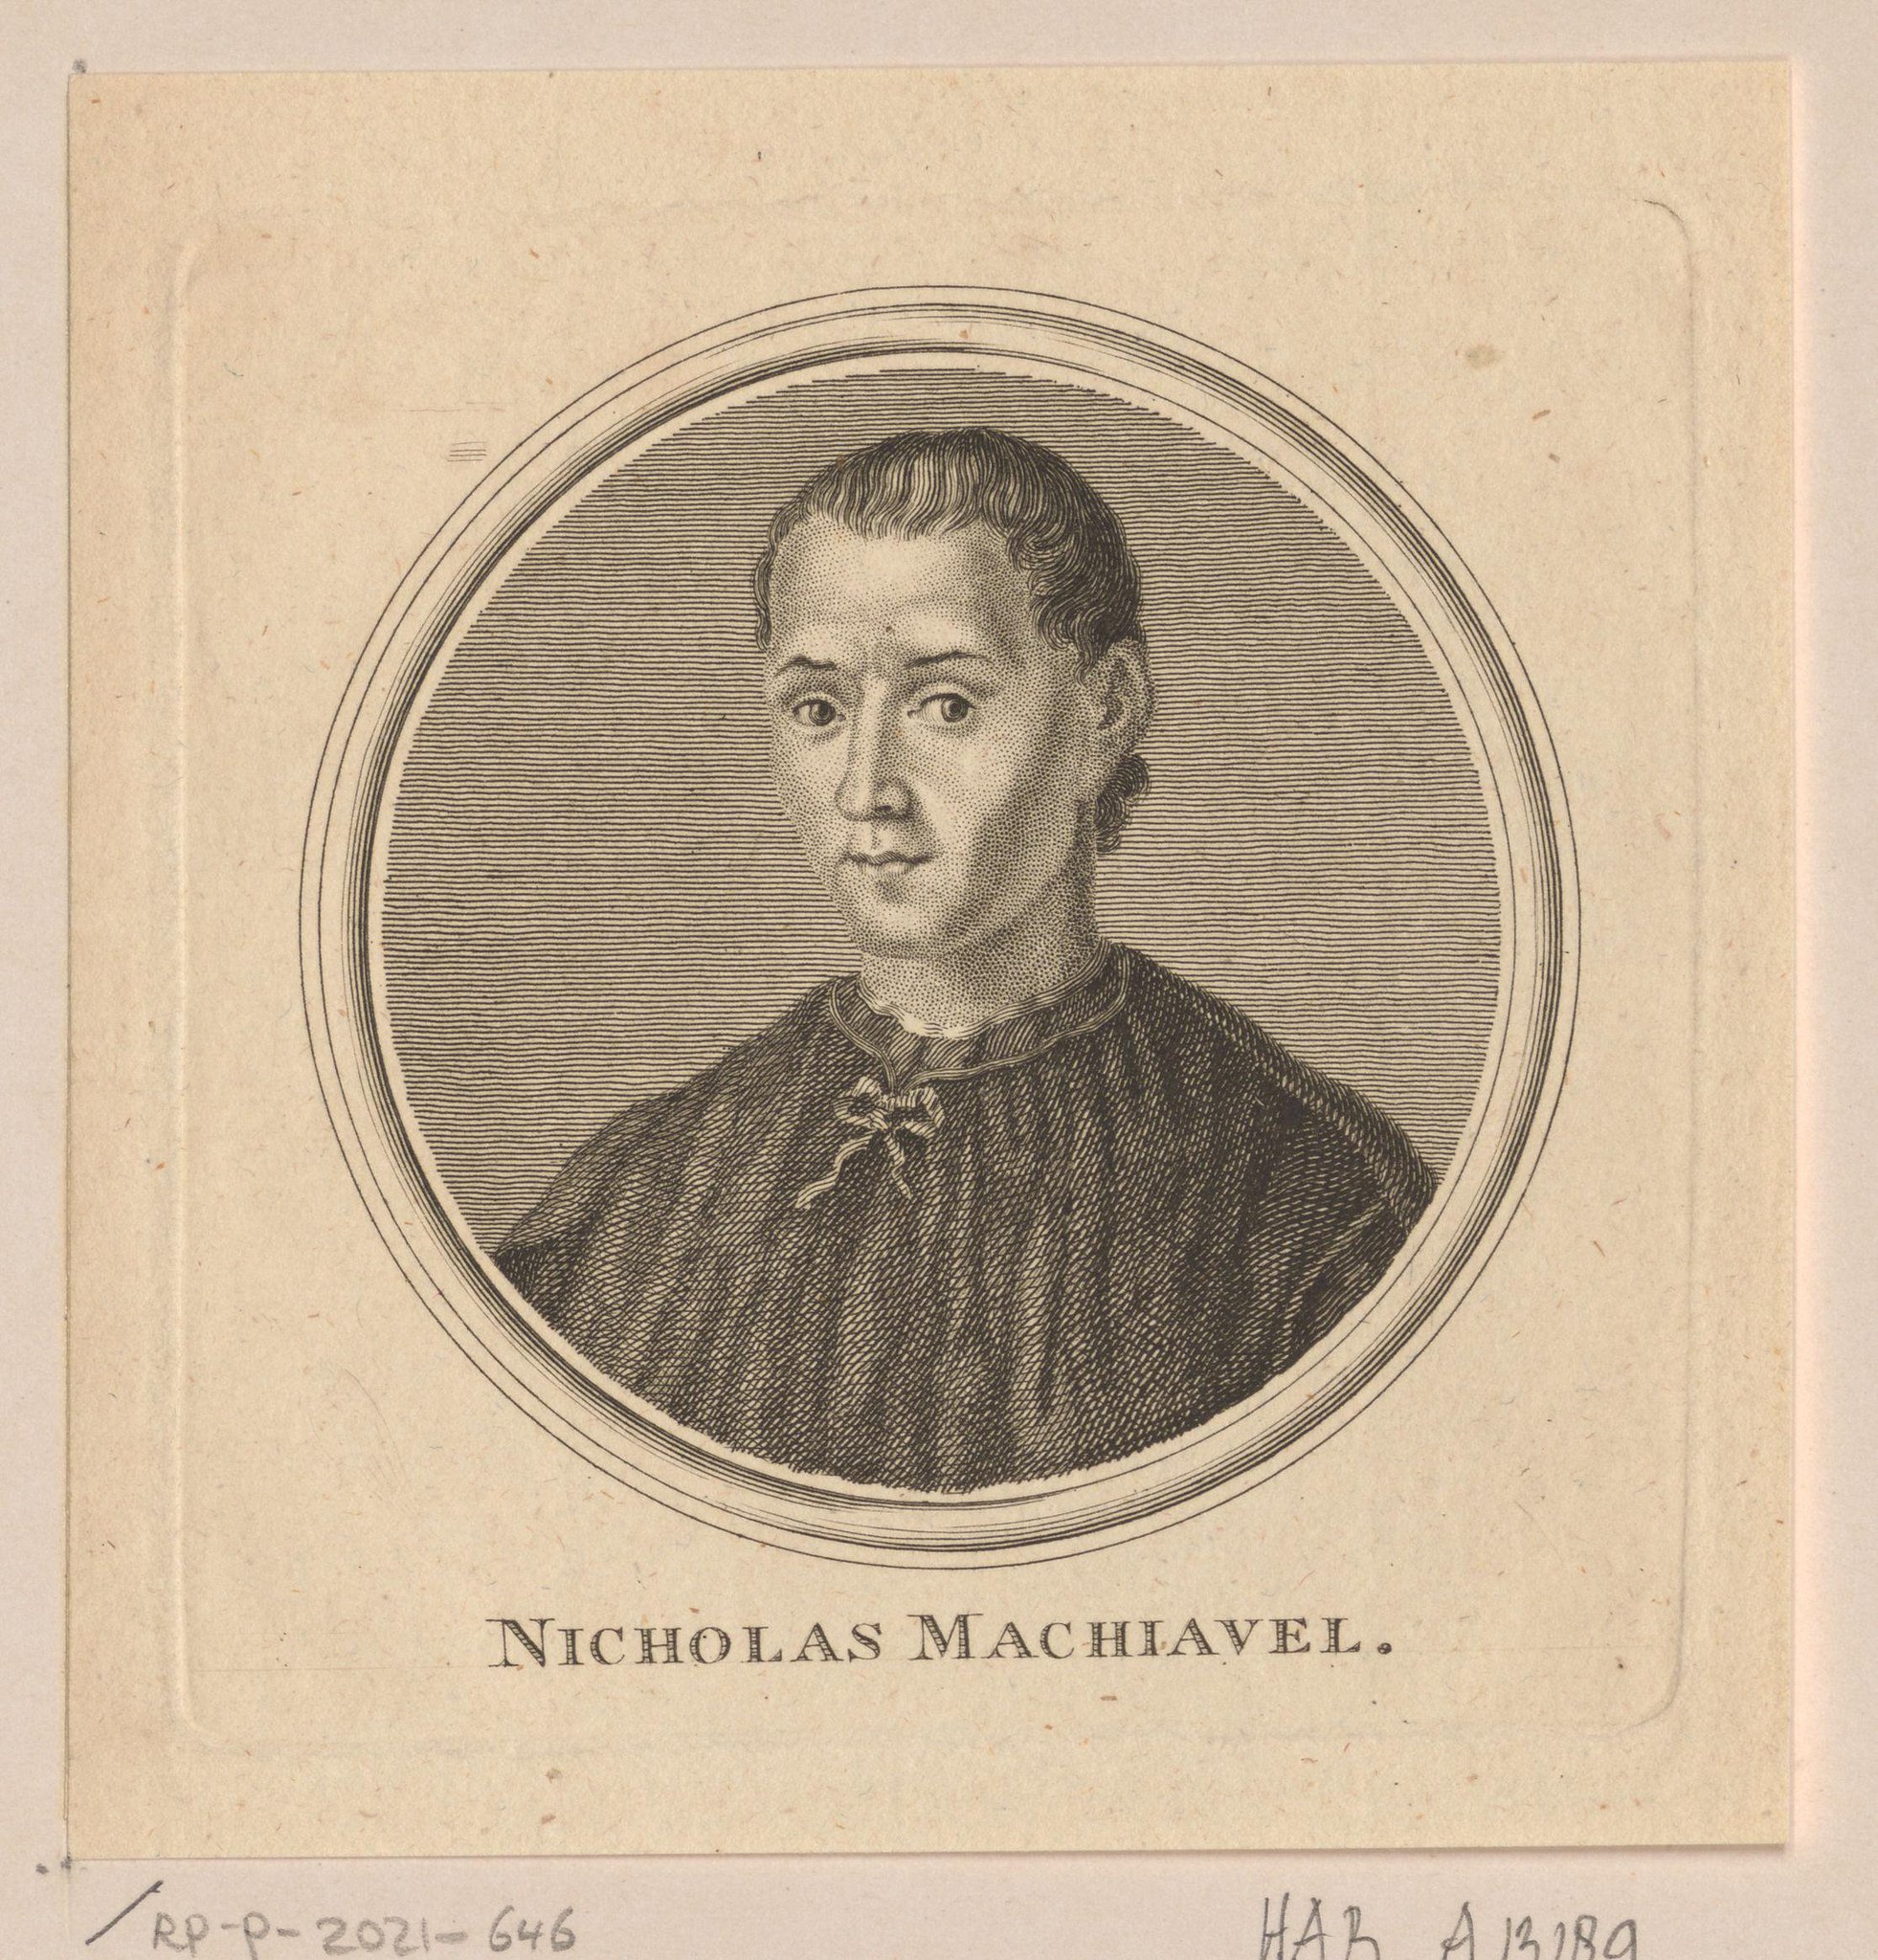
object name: print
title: Portret van Niccolò Machiavelli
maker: Anonymous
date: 1600-1700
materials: paper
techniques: engraving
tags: politician, historical persons, scholar, philosopher (+ portrait of scholar, scientist)